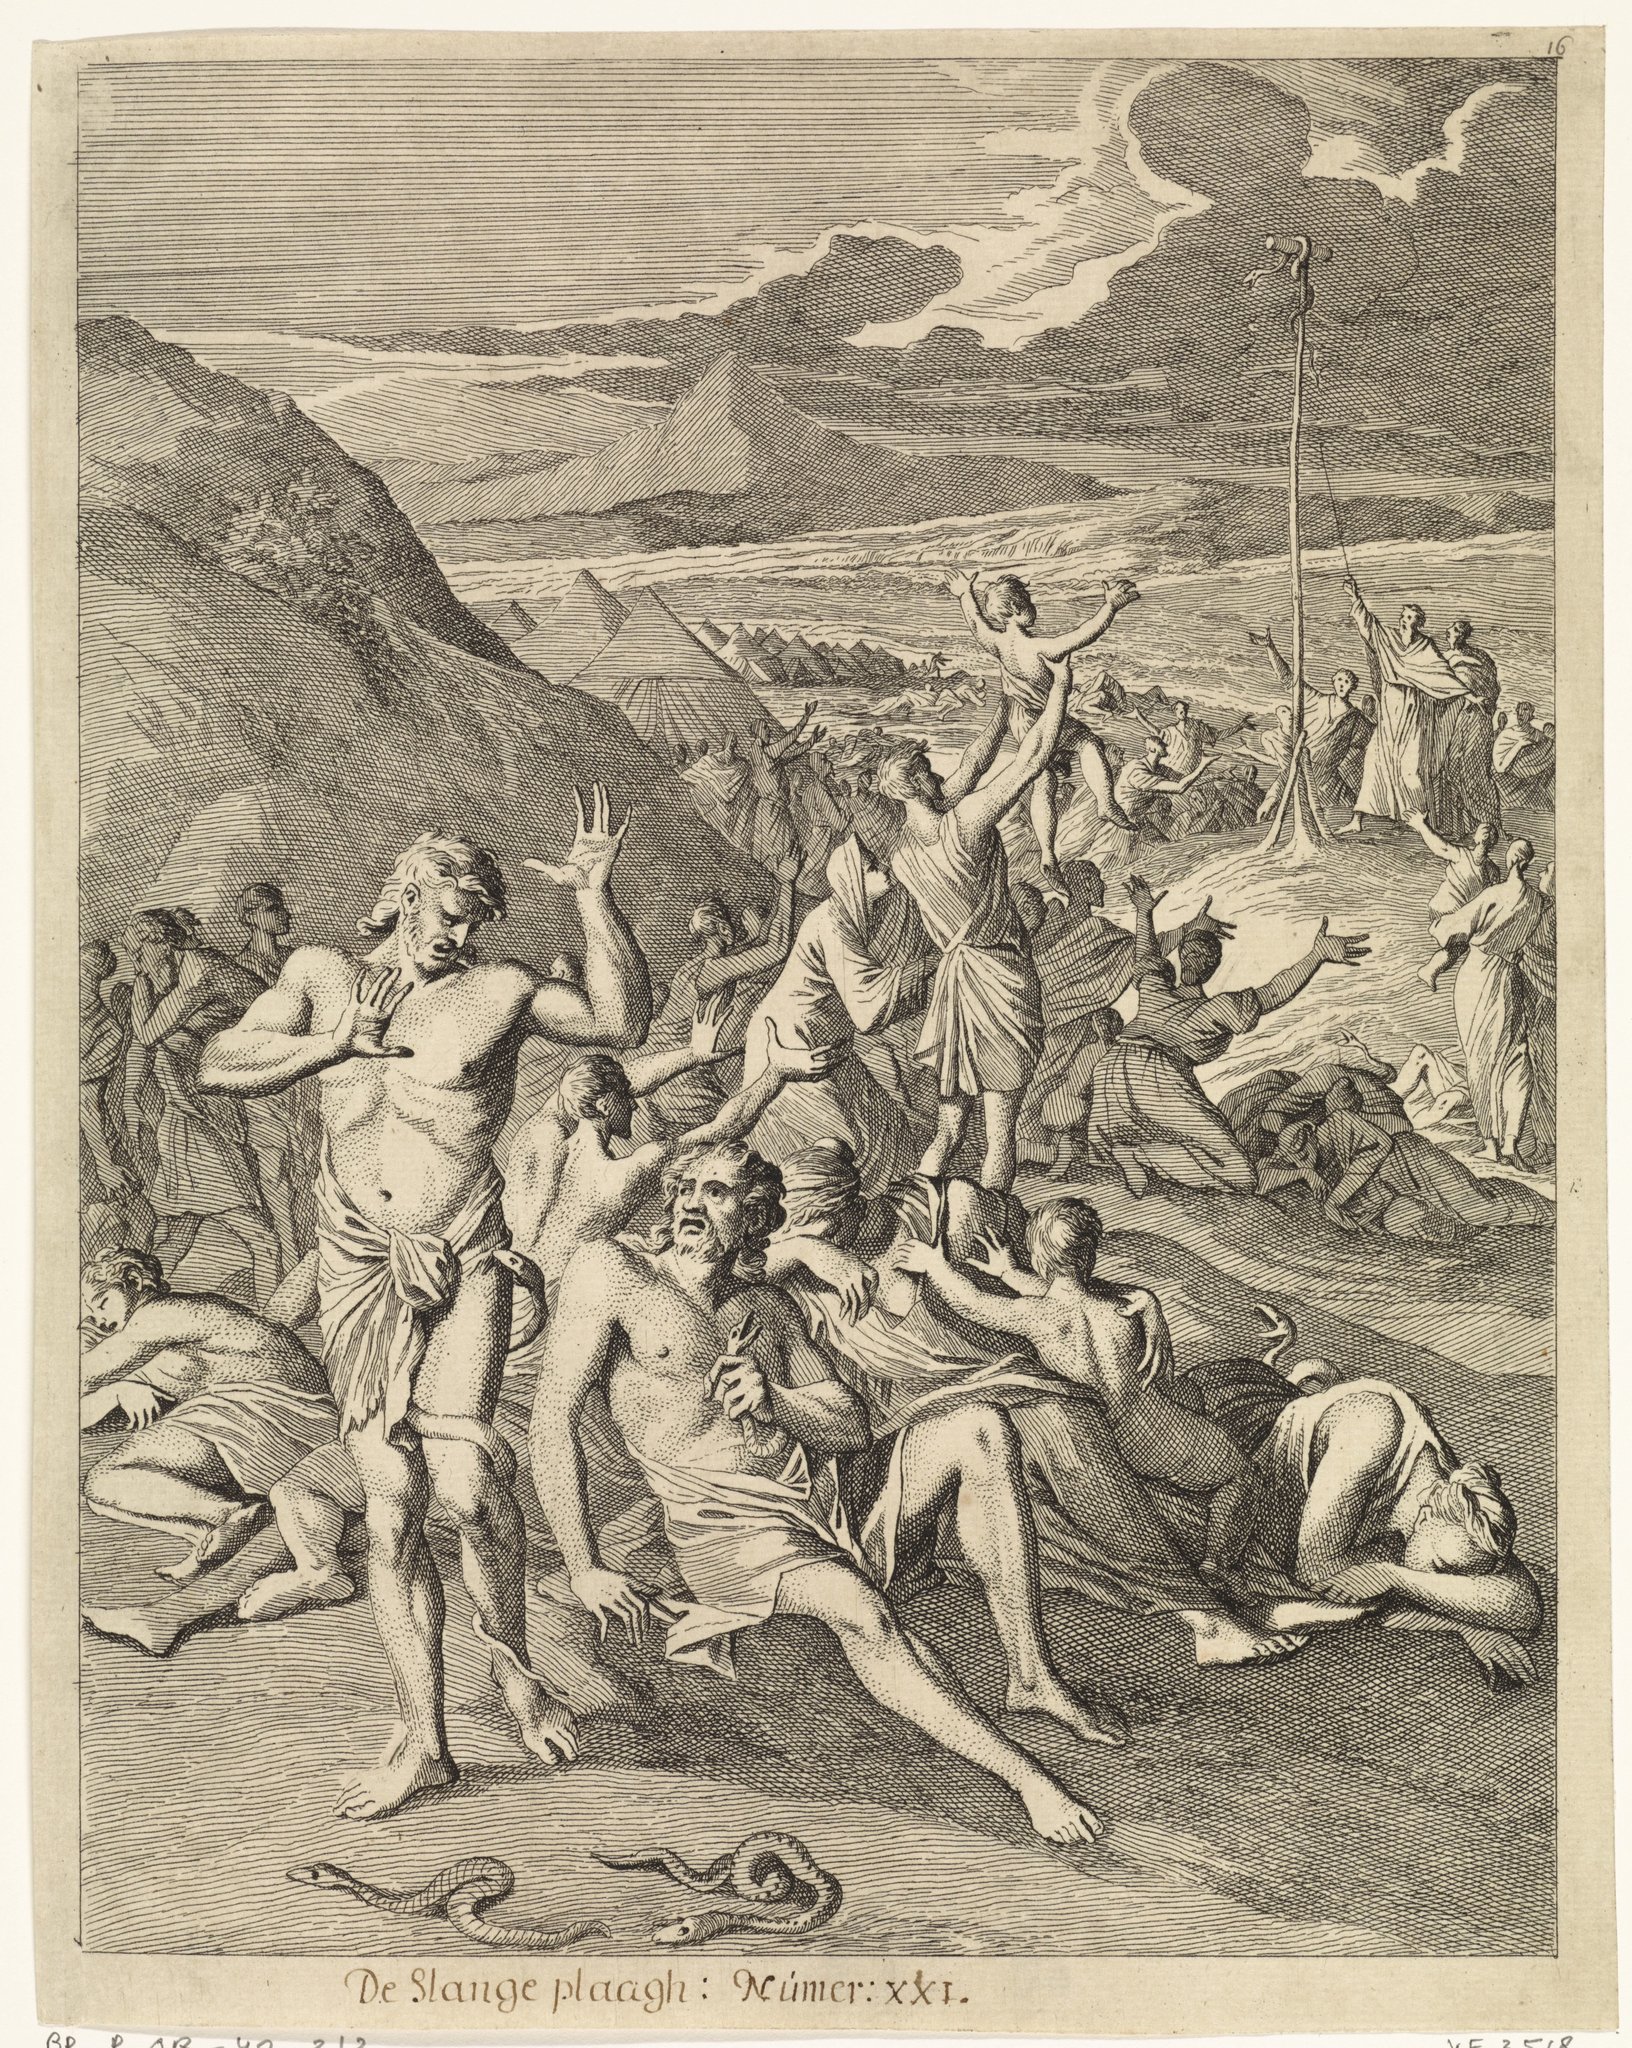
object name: print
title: Mozes toont de koperen slang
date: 1708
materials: paper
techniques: etching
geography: nuremberg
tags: the brazen serpent (numbers 21:4-9)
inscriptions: collector's mark: Lugt 2228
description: Proefdruk van een prent welke is opgenomen als illustratie in: Historiae Celebriores Veteris Testamenti. Christoph Weigel, 1708.